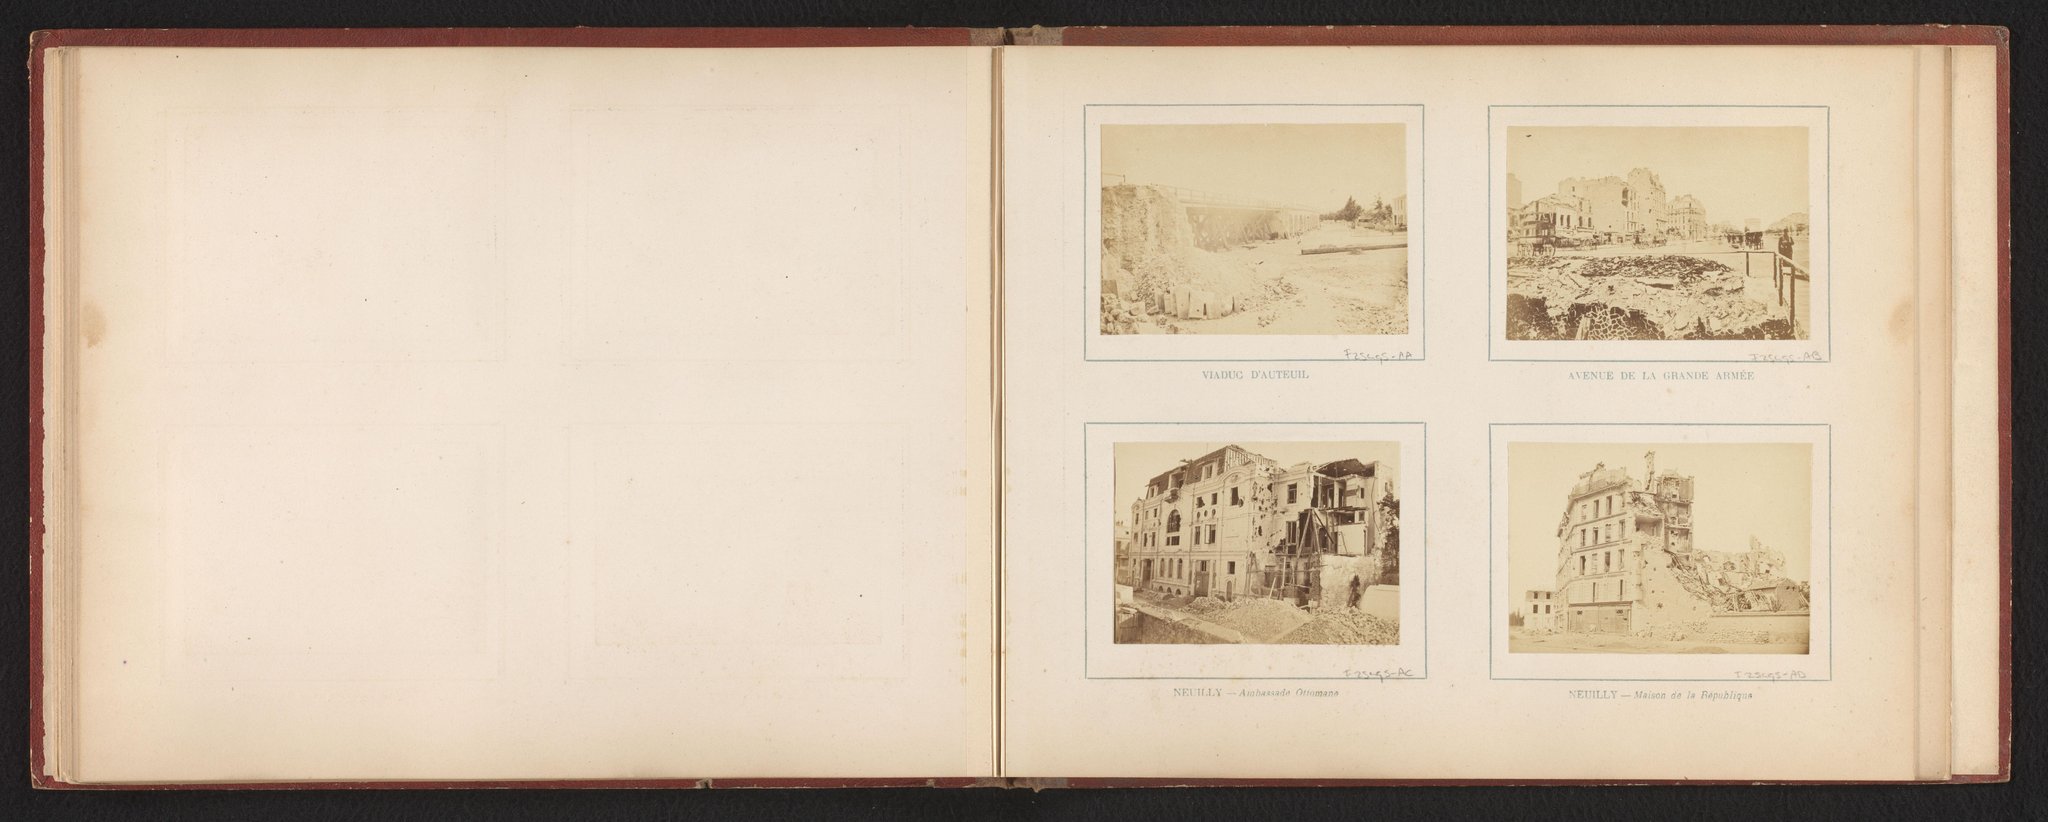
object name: photograph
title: Gezicht op een verwoest gebouw in Neuilly bij Parijs na de semaine sanglante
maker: Anonymous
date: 1871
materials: paper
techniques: albumen print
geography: neuilly-sur-seine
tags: ruin of a building ~ architecture